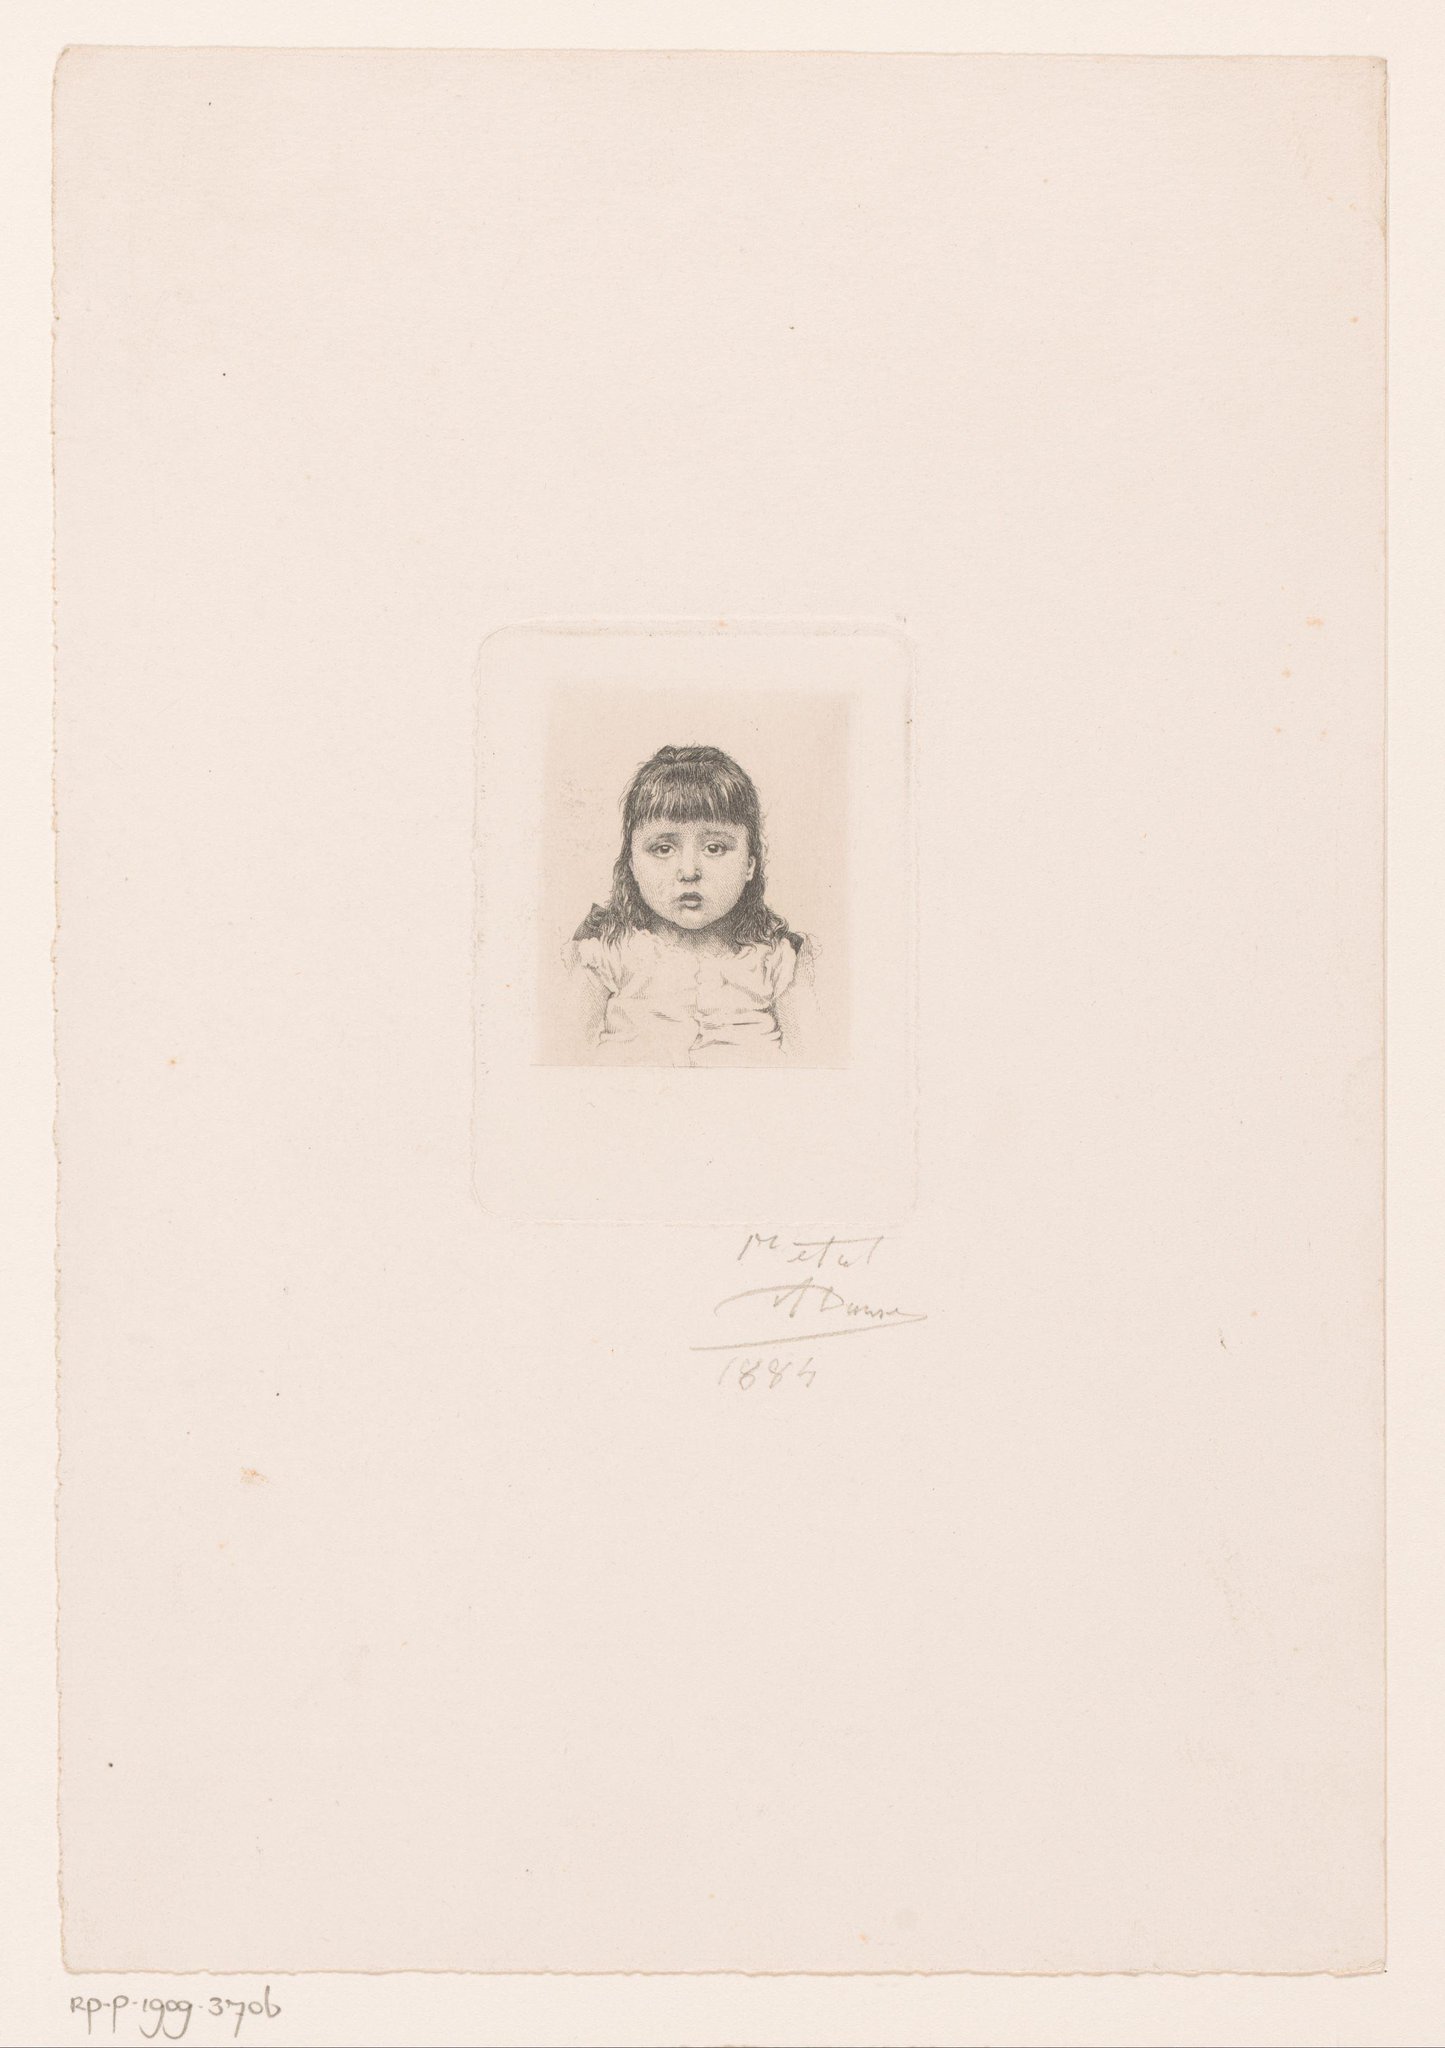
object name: print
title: Lily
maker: auguste danse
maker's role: print maker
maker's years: 1829-1929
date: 1884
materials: paper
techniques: etching, intaglio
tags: adolescent, young woman, maiden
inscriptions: collector's mark: Lugt 2228, annotation: ‘1er etat’